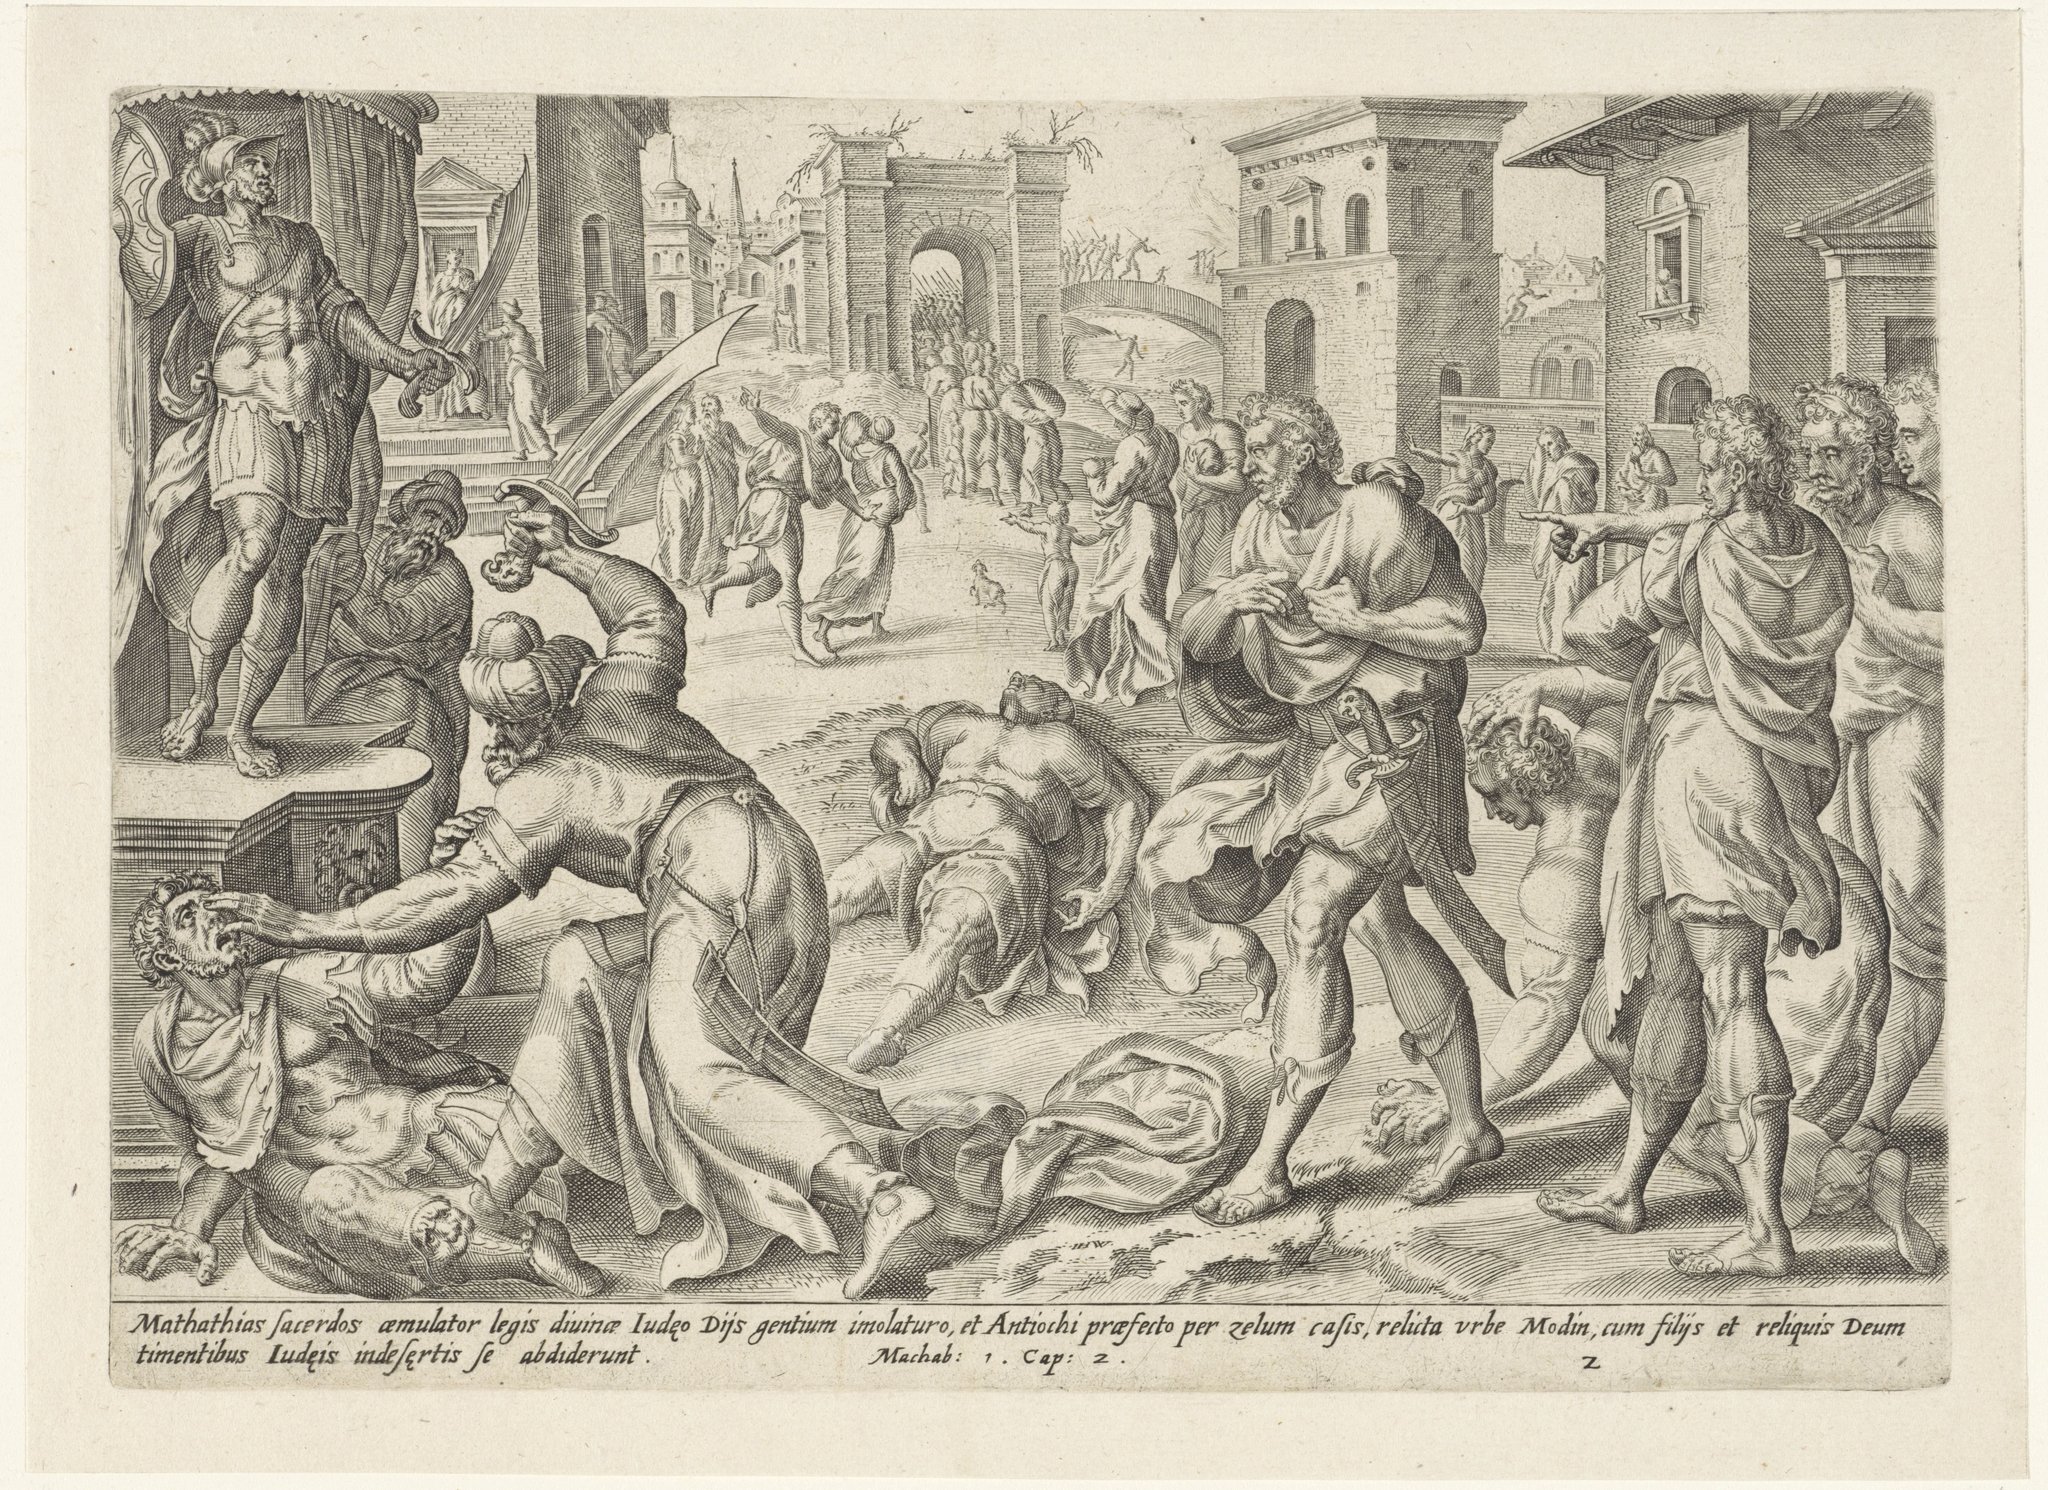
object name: print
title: Thesaurus sacrarum historiarum veteris testamenti (...)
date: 1579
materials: paper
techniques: engraving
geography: antwerp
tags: mattathias kills a jew, who wanted to offer sacrifices to pagan gods, and pulls down the altar in modin (1 maccabees 2:23-26)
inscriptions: collector's mark: Lugt 2228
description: Mattatias doodt een Jood die overeenkomstig het bevel van de koning een offer wilde brengen op het altaar in Modeïn en de afgezant van de koning. Zo toonde hij zijn toewijding aan de wet van God. Onder de voorstelling een verwijzing in het Latijn naar de Bijbeltekst in 1 Makk. 2.